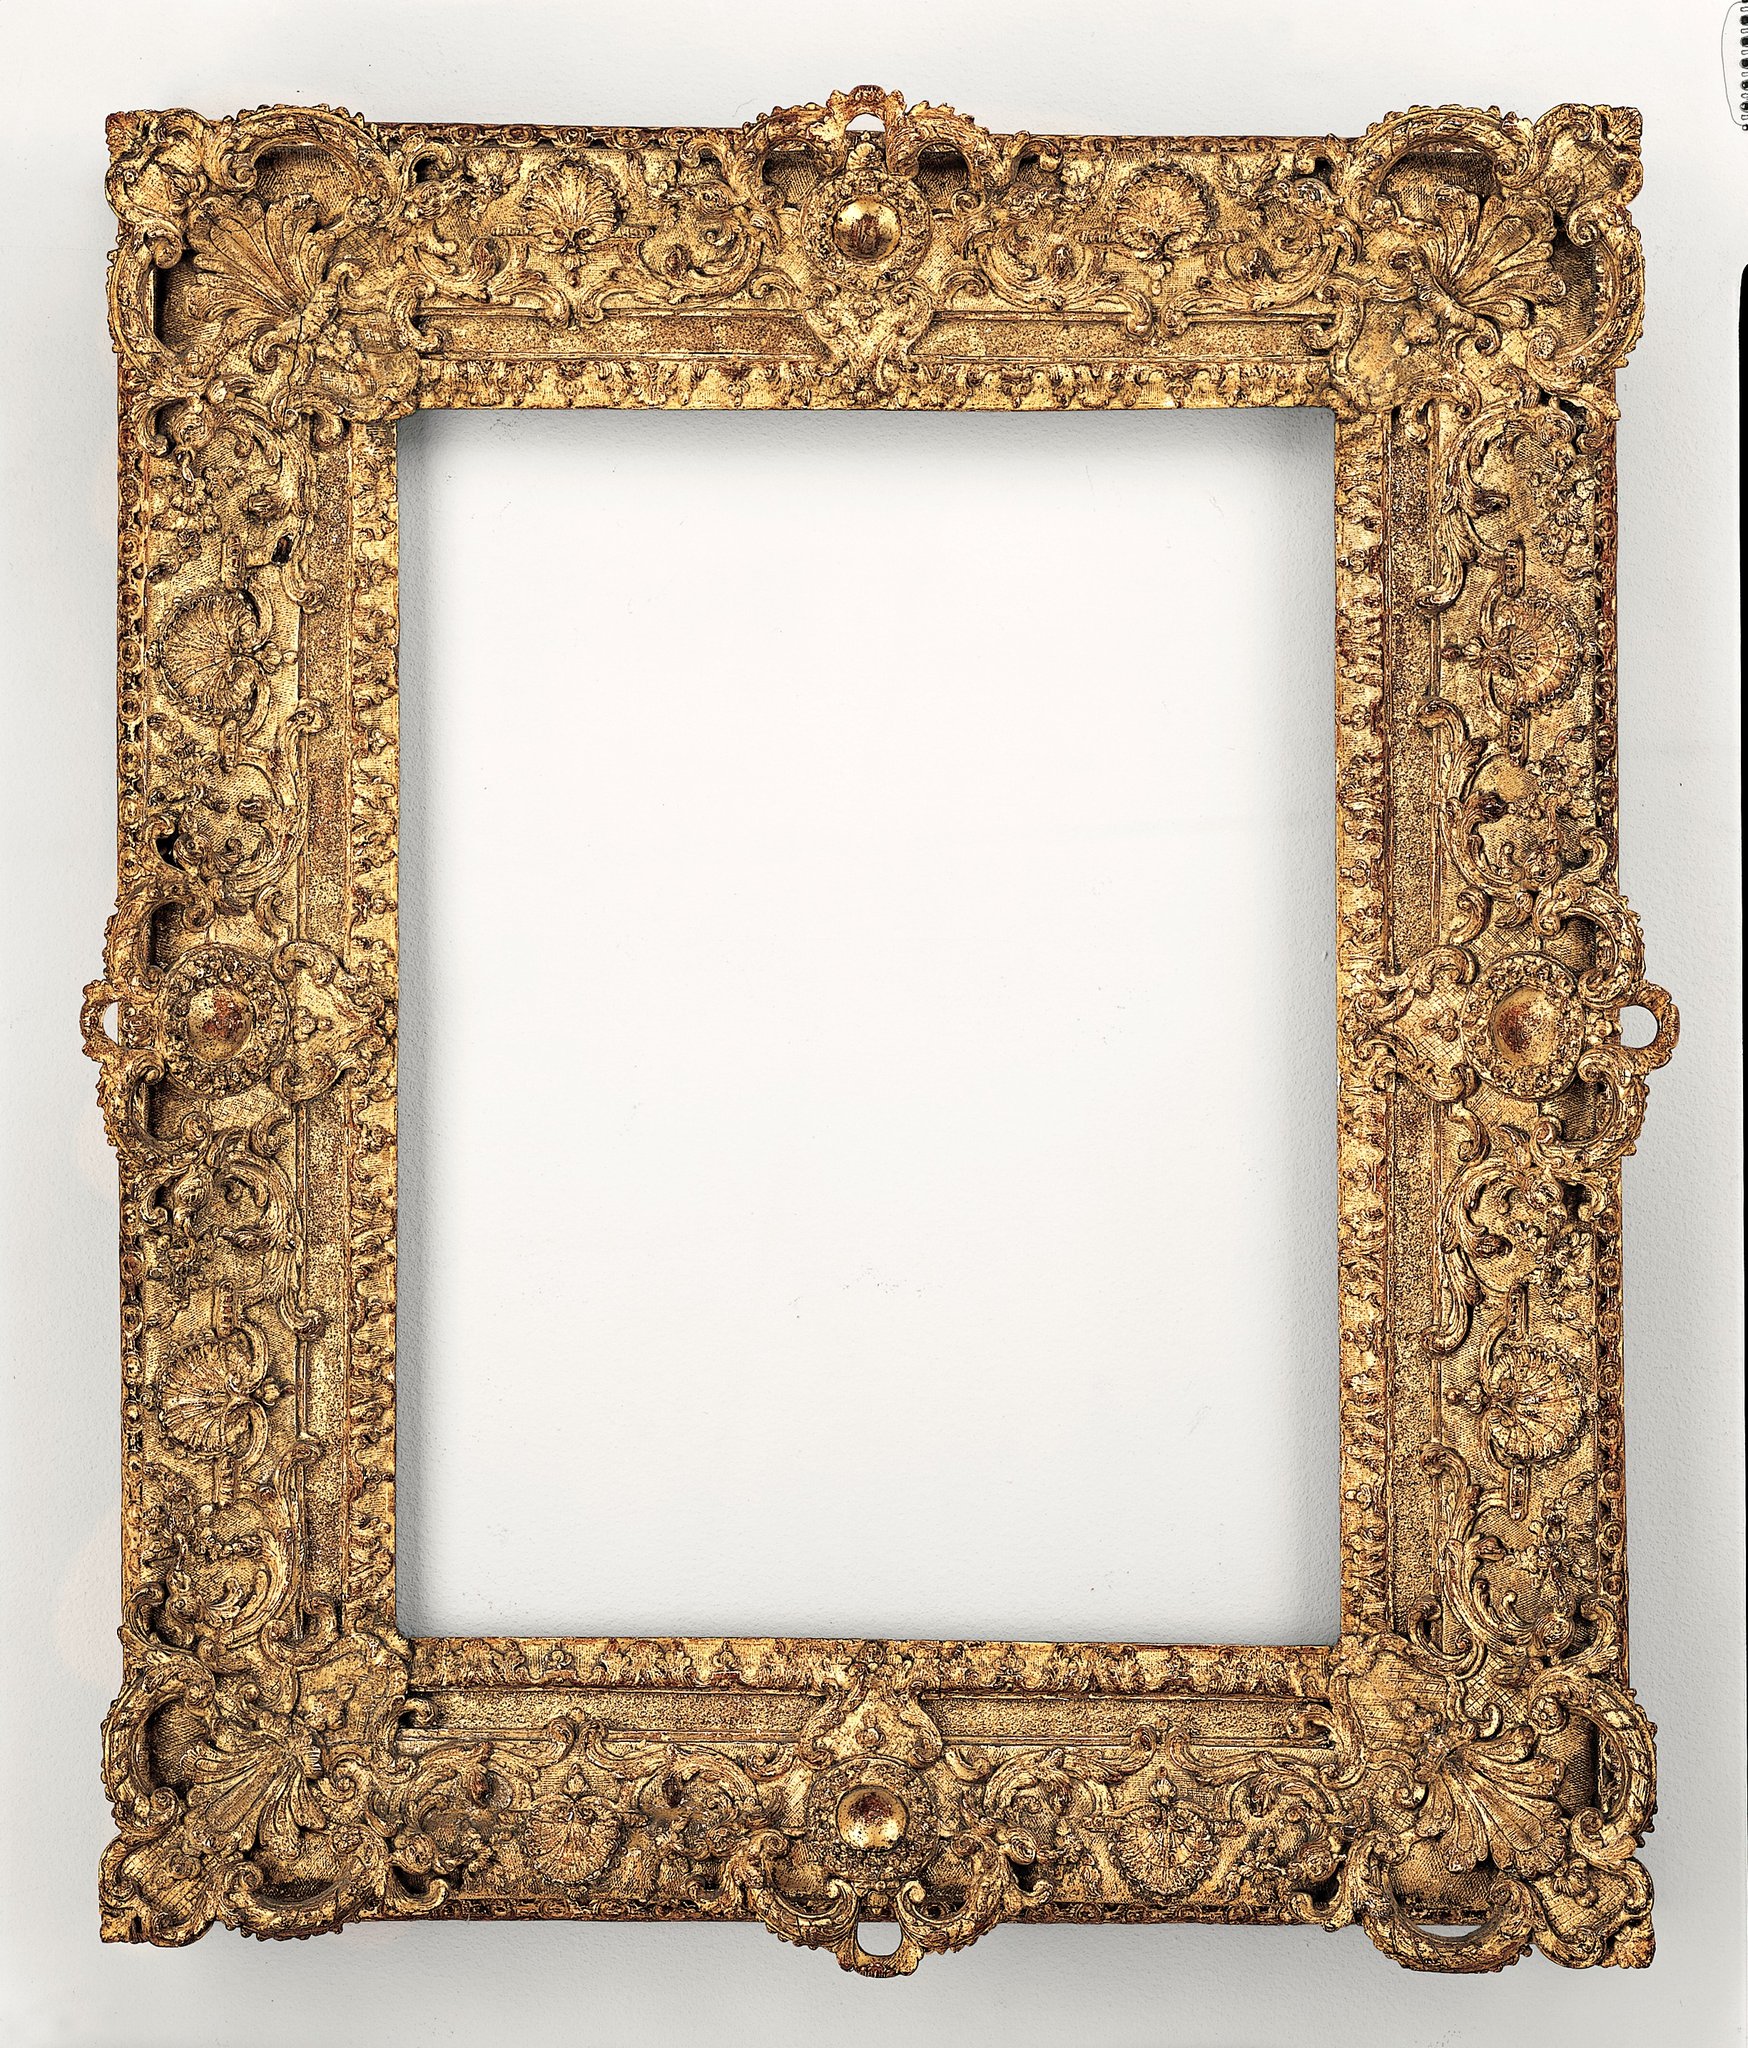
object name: frame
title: Ogee frame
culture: french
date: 1720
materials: wood